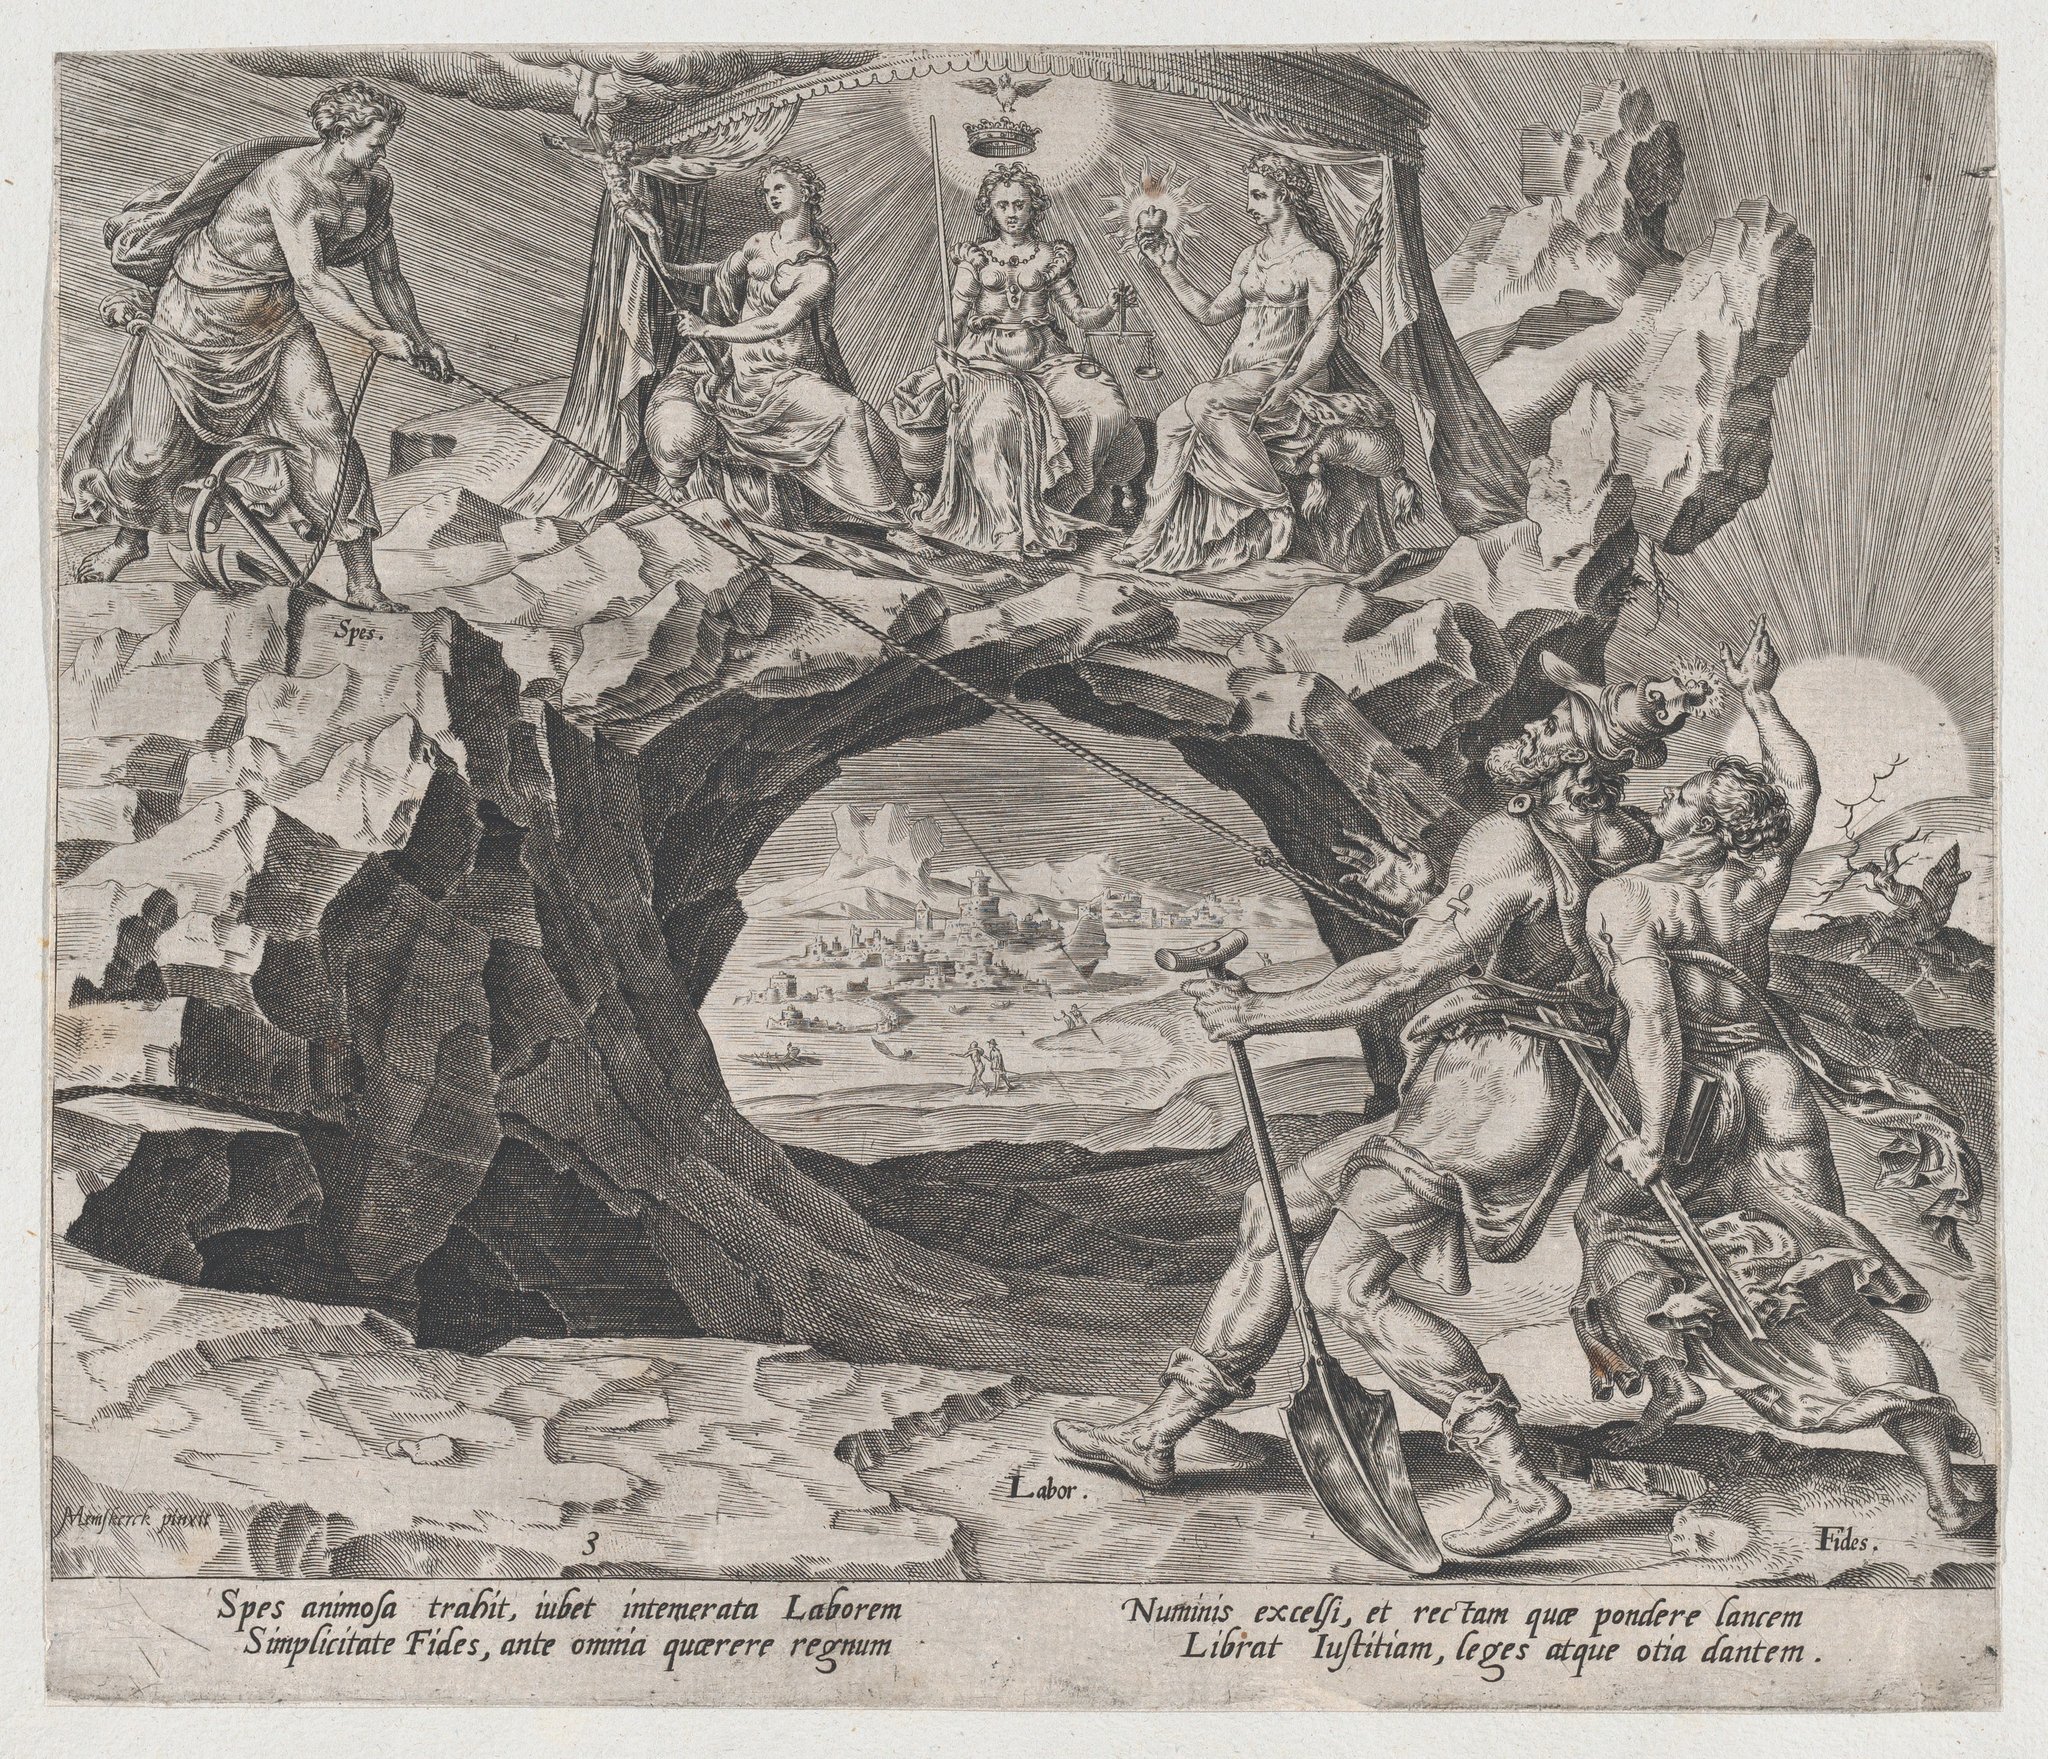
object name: print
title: The Diligent Worker Aspiring to the Righteousness of the Lord, from The Reward of Labour and Diligence, plate 3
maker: philips galle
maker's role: artist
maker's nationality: netherlandish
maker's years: 1537-1612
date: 1572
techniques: engraving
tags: men,women